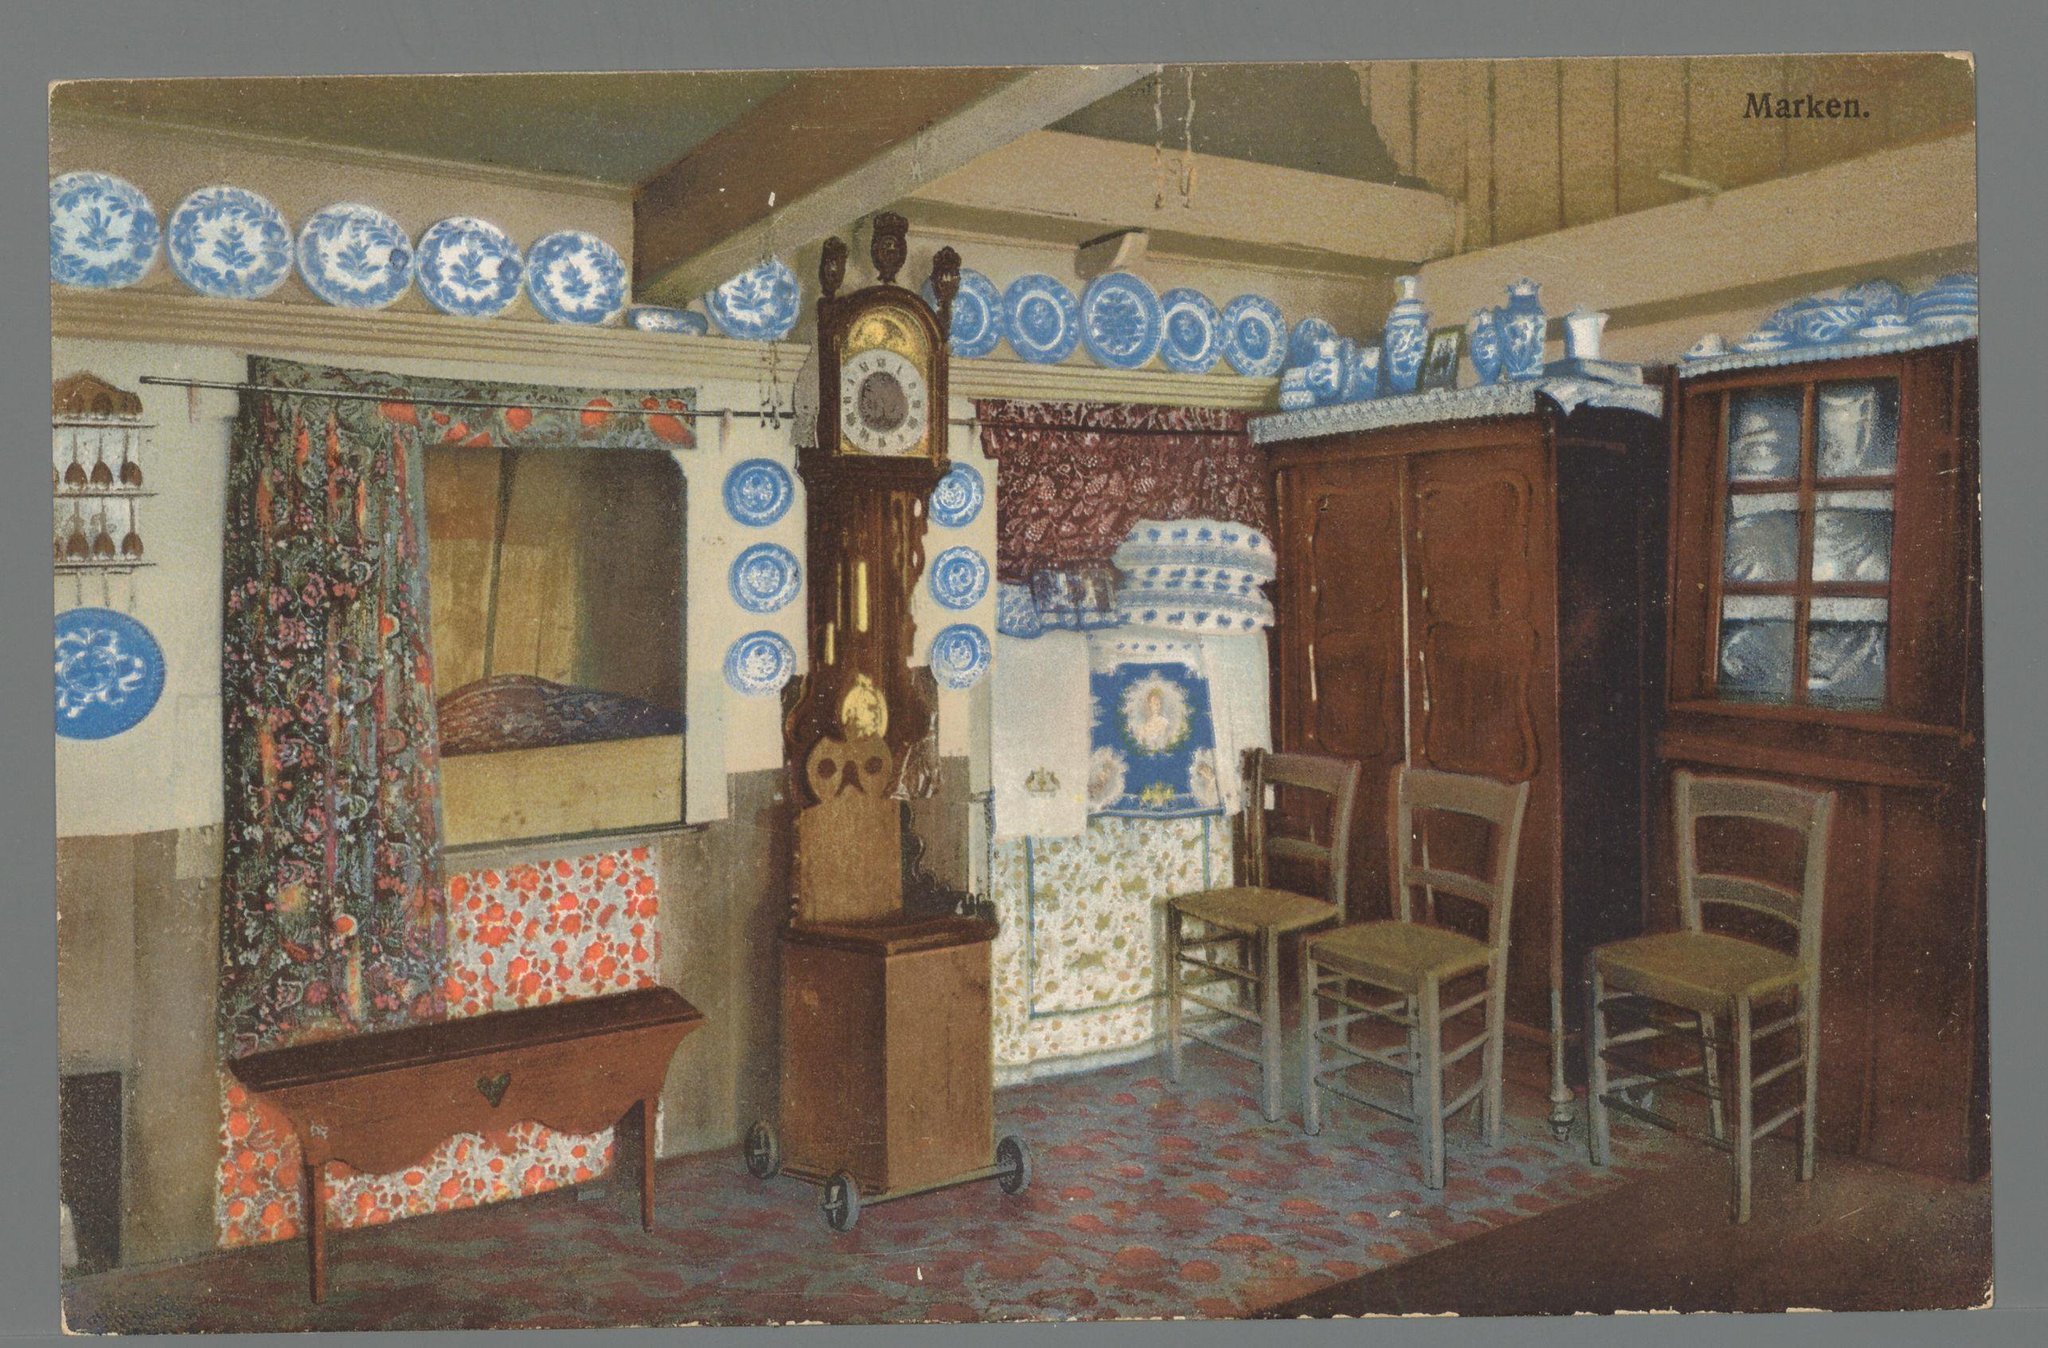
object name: photomechanical print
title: Marken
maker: Anonymous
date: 1906-1945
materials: cardboard, photographic process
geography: dresden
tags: interior of the house, built-in bedstead (dutch: 'bedstee')